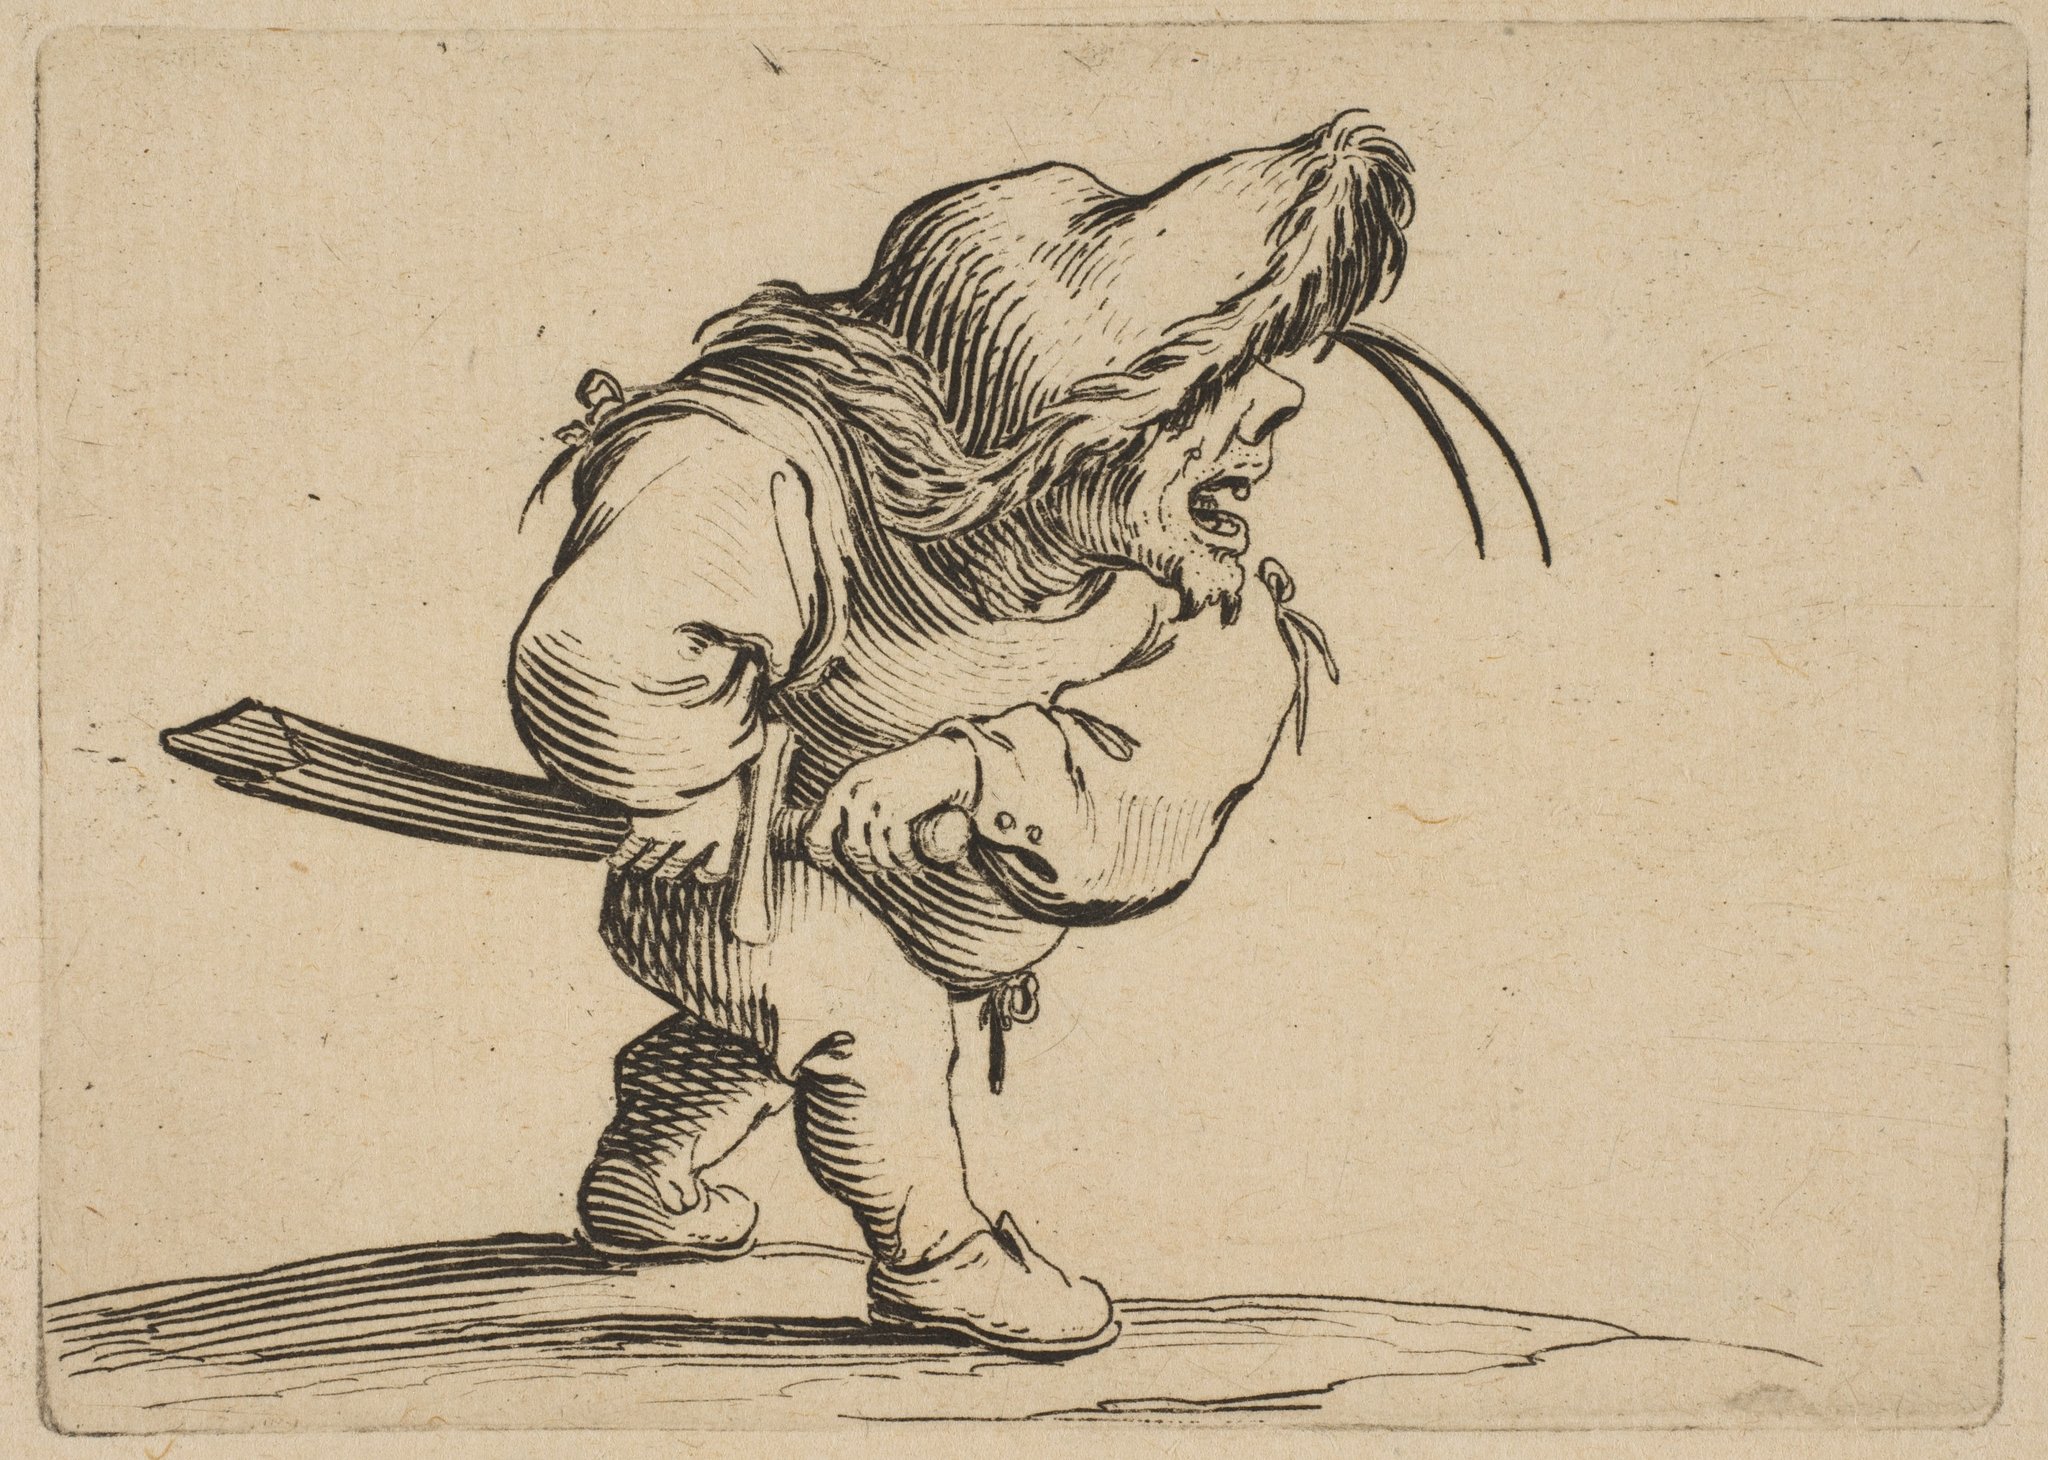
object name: print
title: L'Homme S'Apprêtant a Tirer son Sabre (Man Preparing to Draw his Sword), from "Varie Figure Gobbi, suite appelée aussi Les Bossus, Les Pygmées, Les Nains Grotesques" (Various Hunchbacked Figures, The Hunchbacks, The Pygmes, The Grotesque Dwarfs)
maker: jacques callot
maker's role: artist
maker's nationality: french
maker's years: 1592-1635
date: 1616-1622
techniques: etching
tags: swords,men